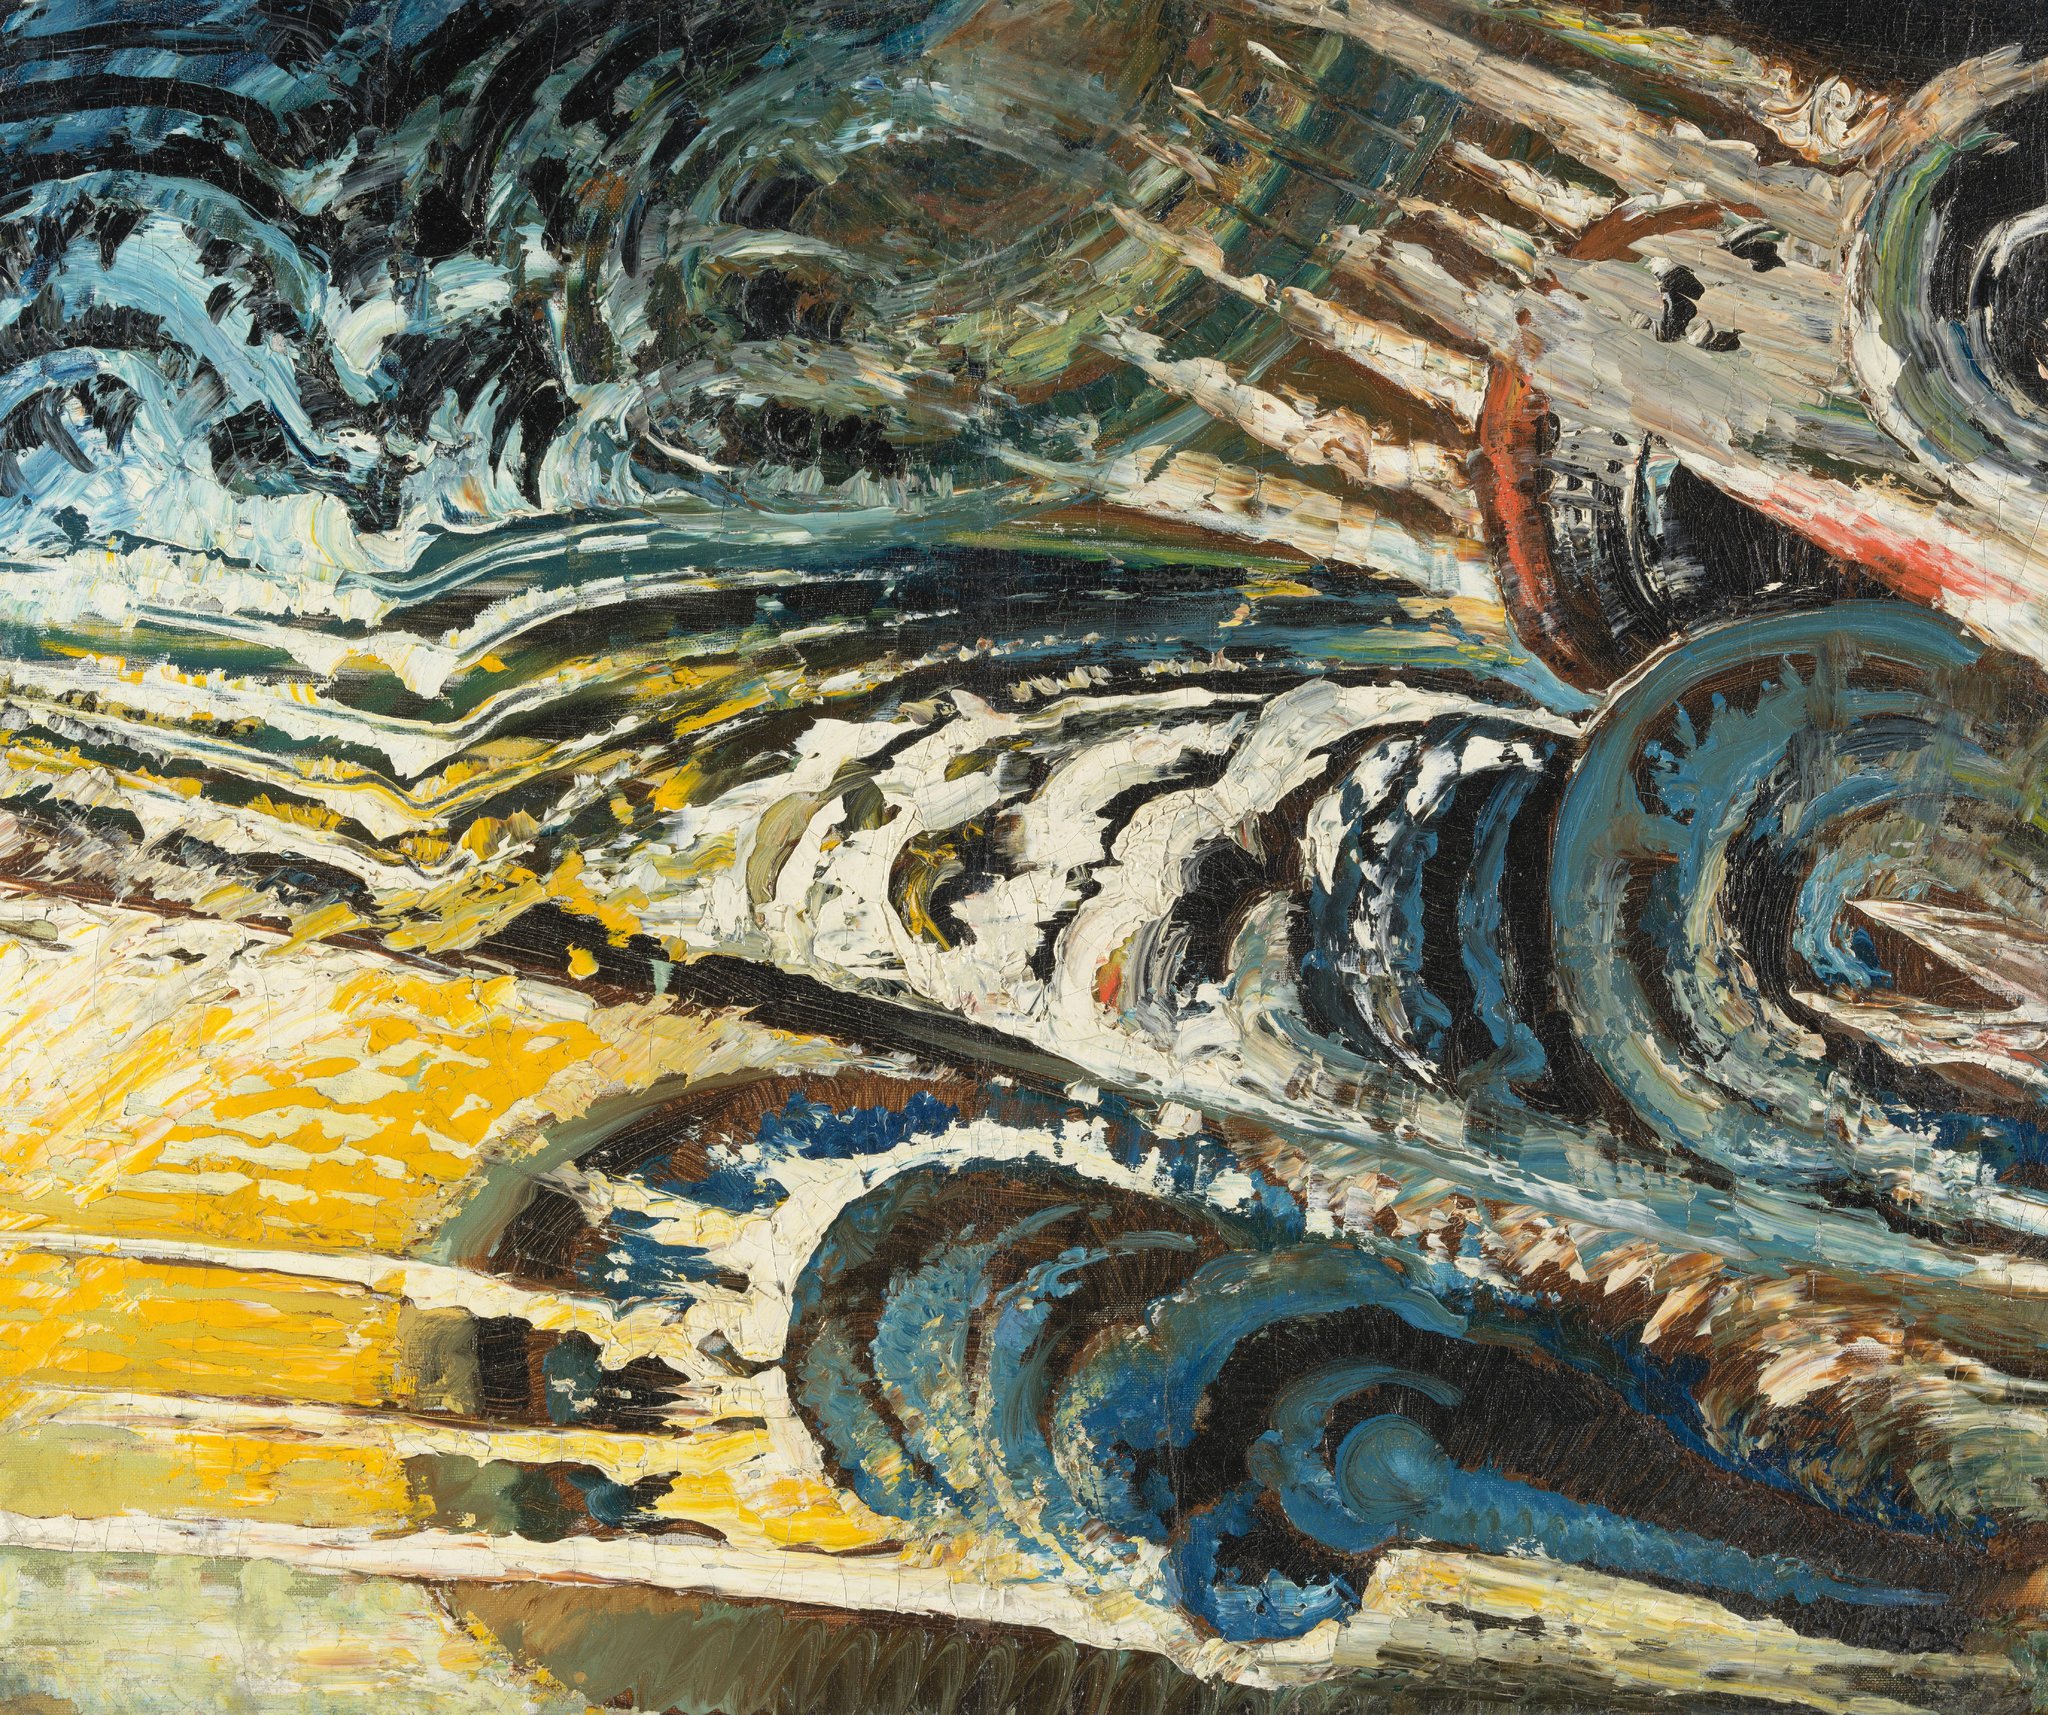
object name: painting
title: Abstract-futurist Composition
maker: chris lanooy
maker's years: 1881-1948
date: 1912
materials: canvas, oil, paint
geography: gouda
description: In 1912-1913 paintings by Italian Futurists were exhibited in various Dutch cities. Their picturing of movement with ‘lines of force,’ as they called them, was unprecedented. While Futurism became a hype in the newspapers, it found less resonance among Dutch artists. An exception was the Gouda ceramist and painter Chris Lanooy. His dynamic composition of rays and circles evokes the image of an explosion, or a car racing by.